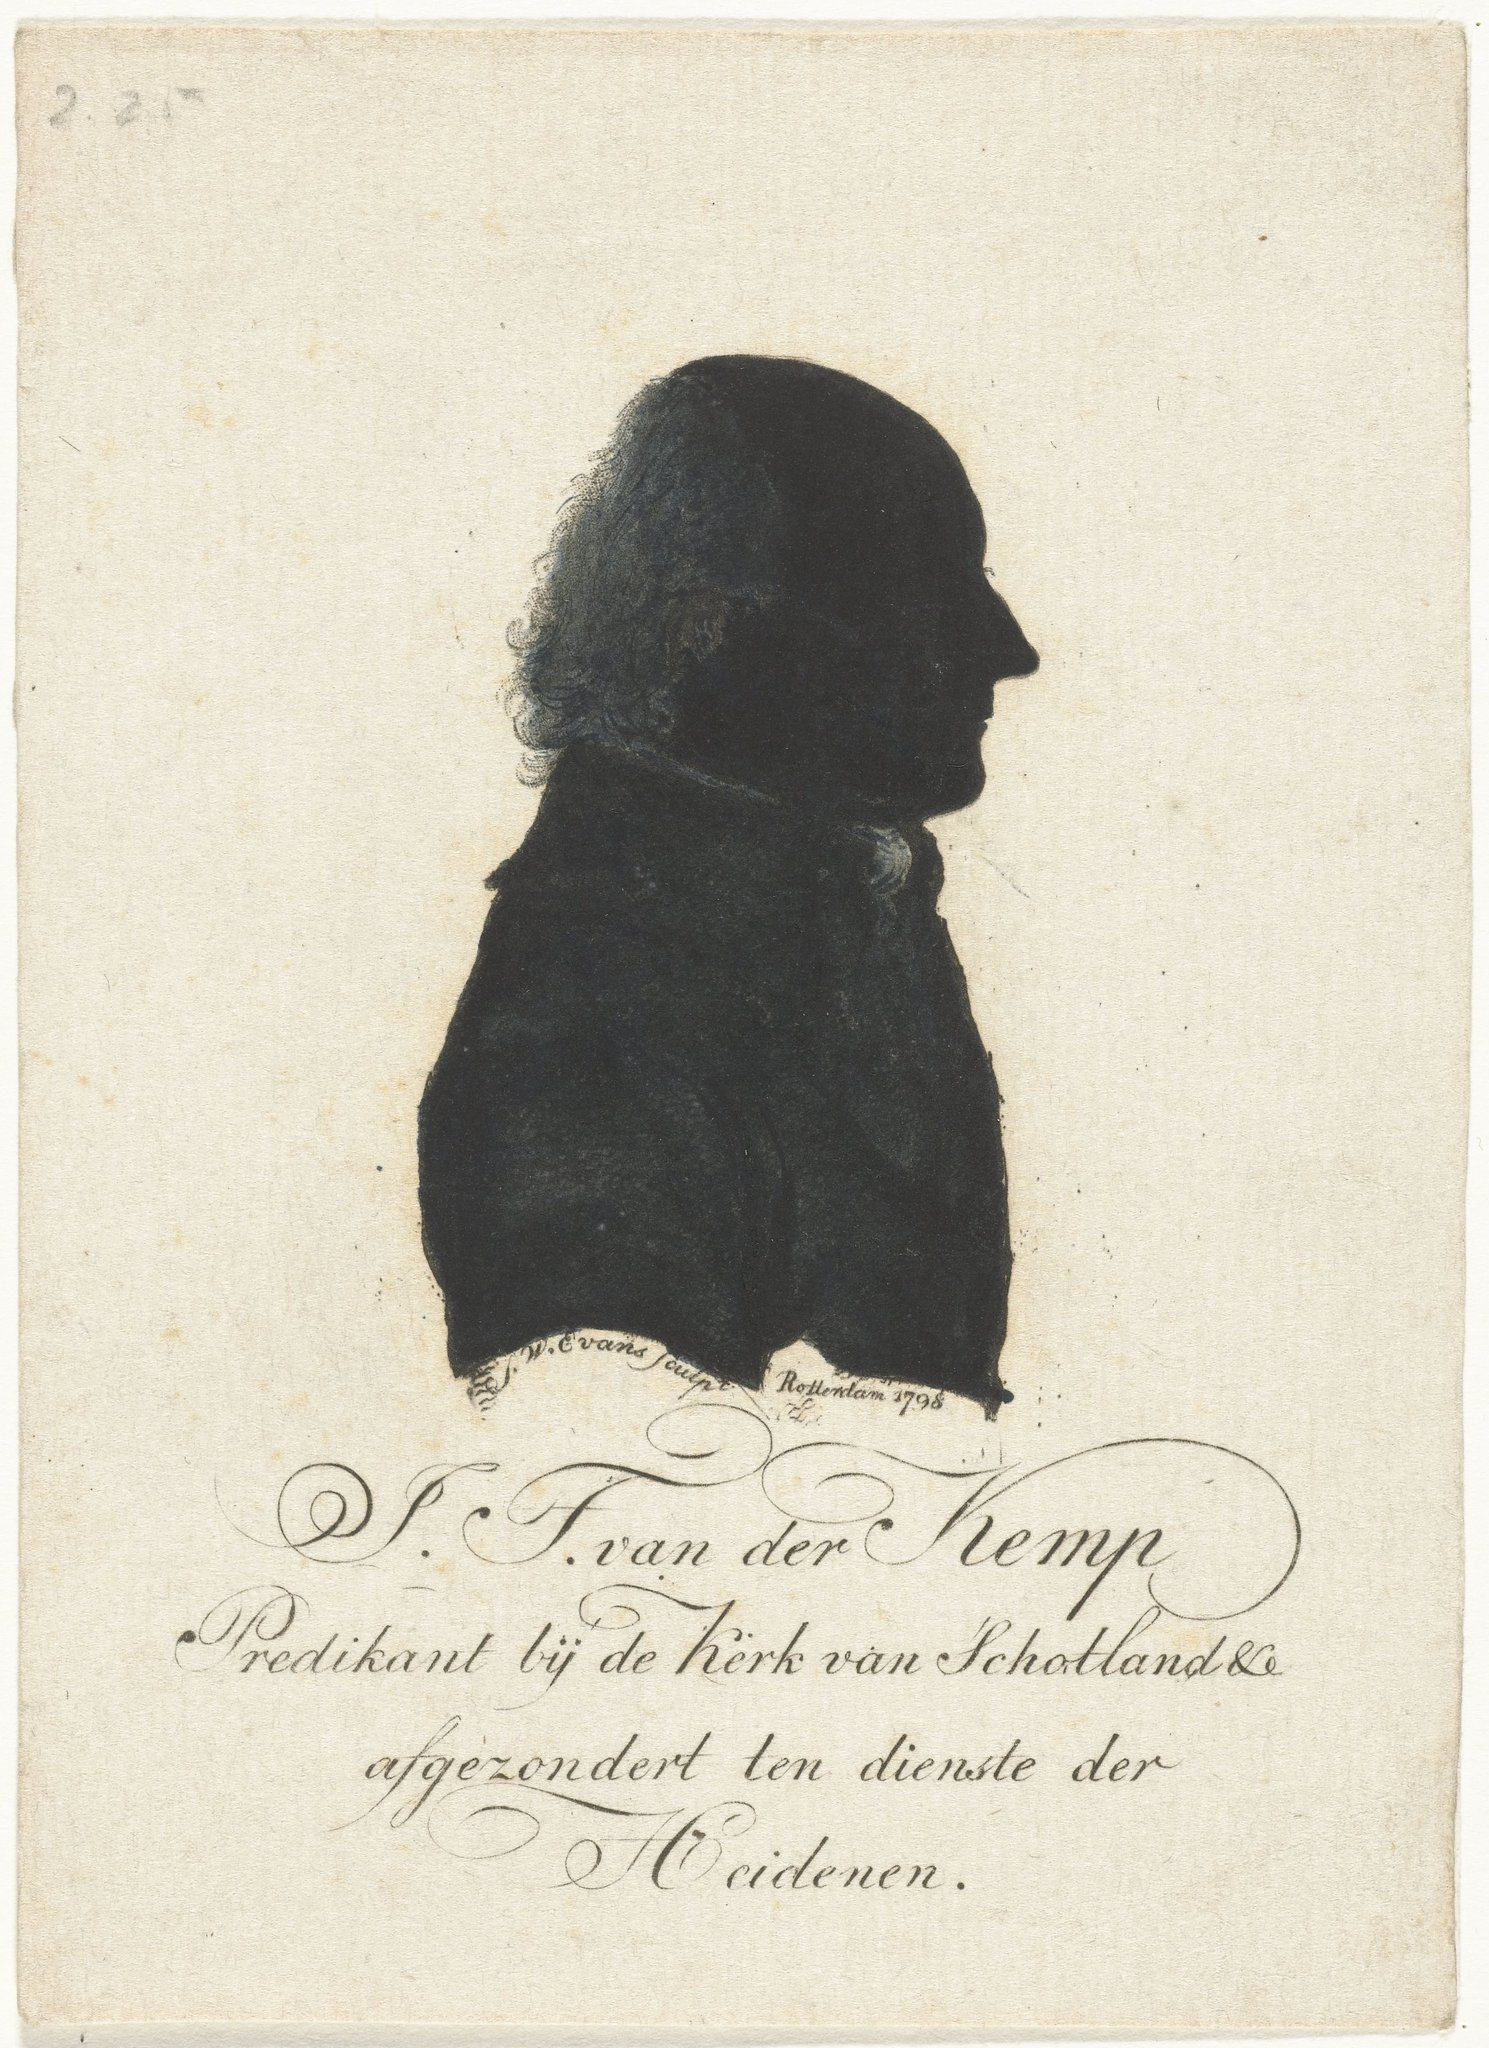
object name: print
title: Silhouetportret van Johannes Theodorius van der Kemp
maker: sophia wilhelmina evans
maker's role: print maker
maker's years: 1772-1816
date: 1798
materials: paper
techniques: etching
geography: rotterdam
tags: kaapstad, predikant, johannes theodorus van der kemp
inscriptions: collector's mark: Lugt 2228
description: Bustesilhouet en profil van de predikant Johannes Theodorus van der Kemp. Onder het silhouet een Nederlandse tekst in vier regels.